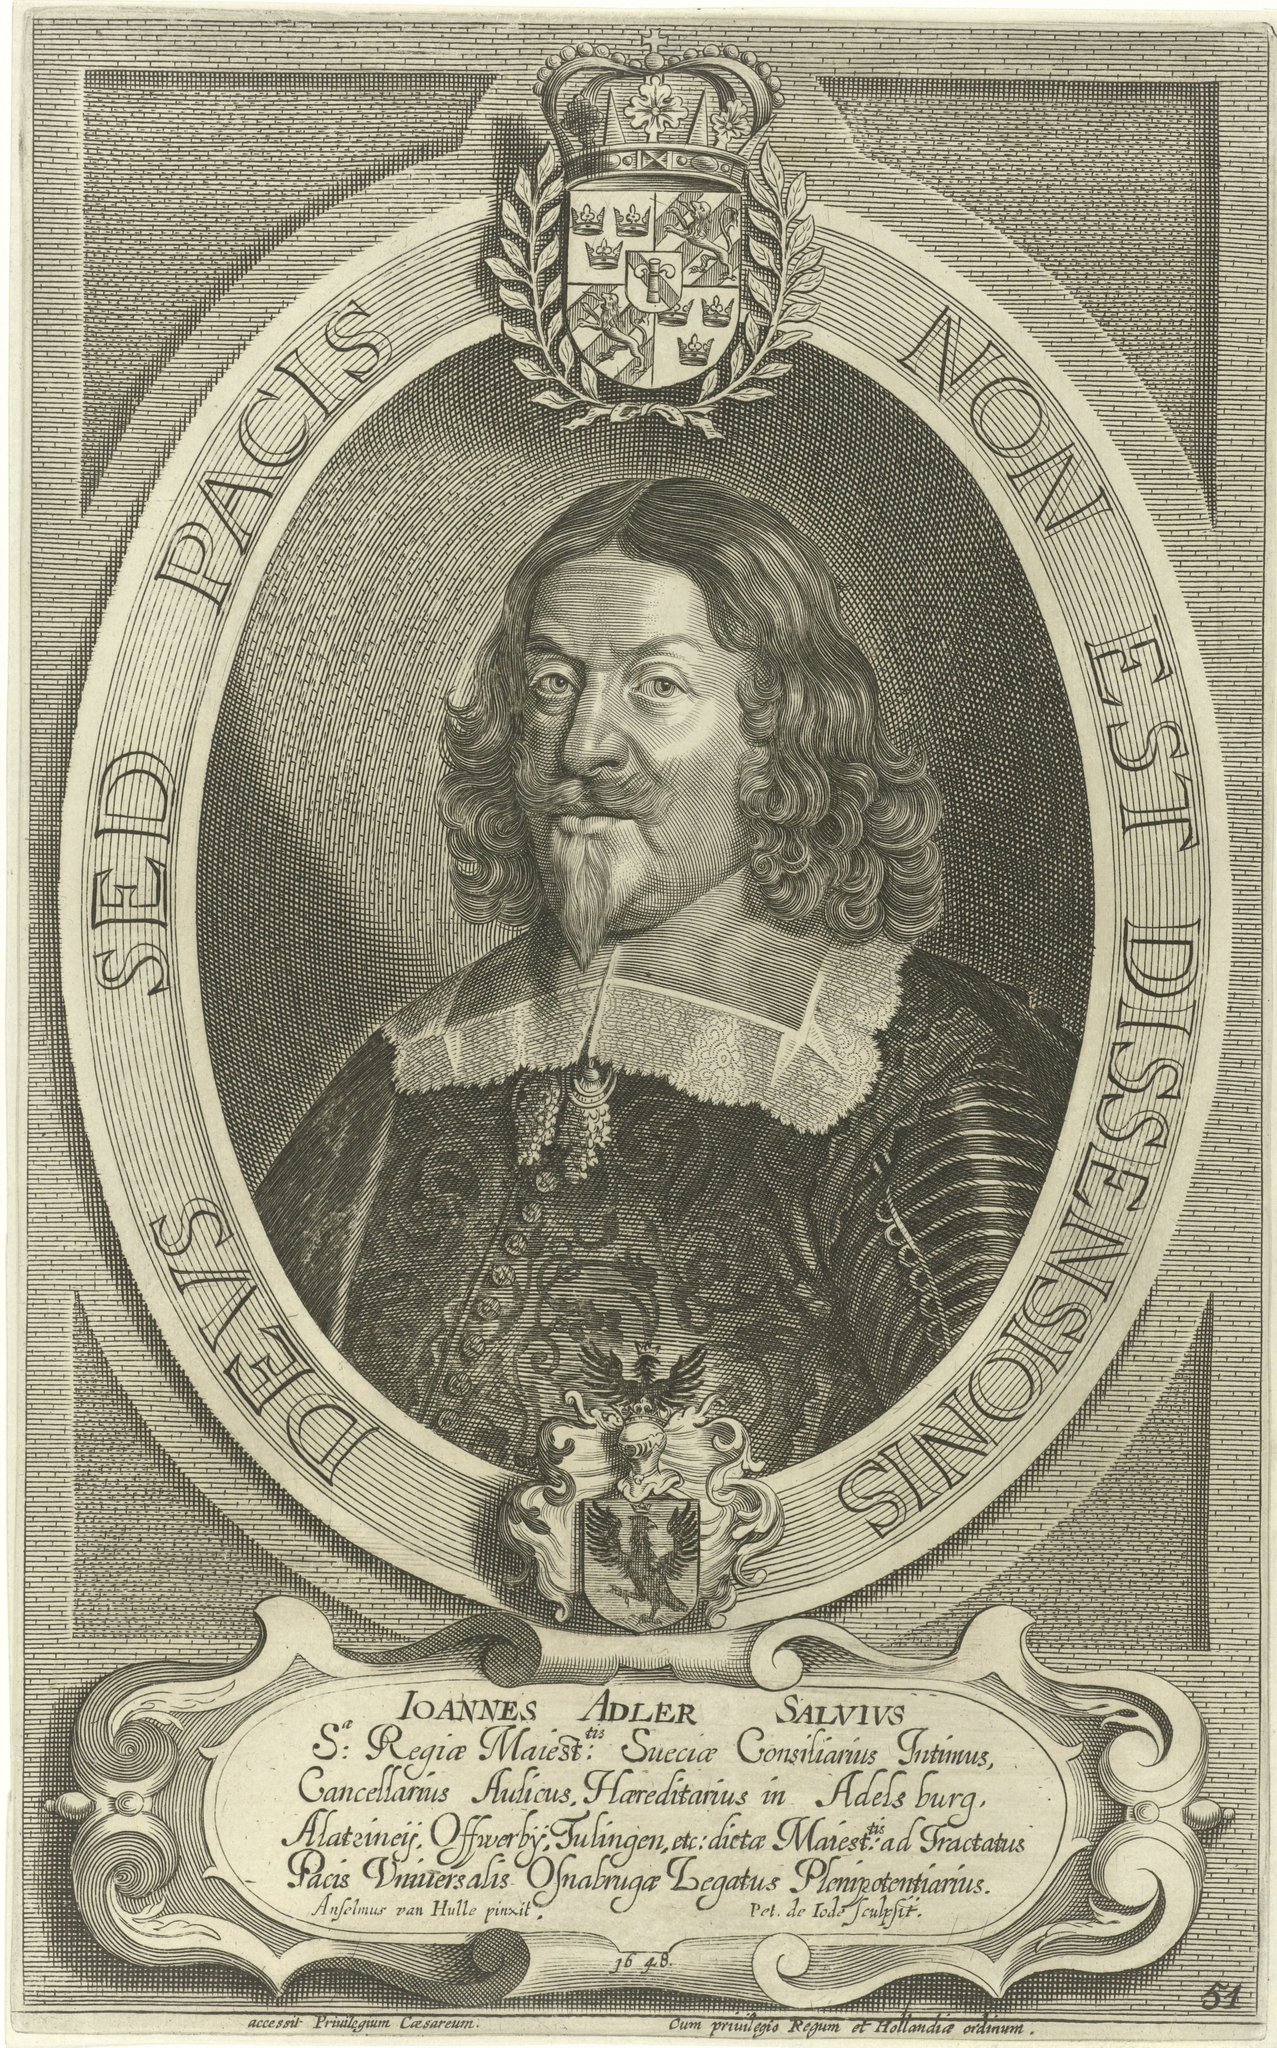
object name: print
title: Hommes illustres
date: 1648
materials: paper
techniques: engraving, etching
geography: antwerp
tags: strängnäs, stockholm, diplomaat, johan adler salvius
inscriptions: collector's mark: Lugt 2228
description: Busteportret van Johan Adler Salvius. Rechtsonder: 51. Het portret is gevat in een ovale omlijsting met vierkant randwerk, het wapenschild van de geportretteerde en een randschrift in het Latijn. In de cartouche een vijfregelig onderschrift in het Latijn. Prent uit een serie portretten naar schilderijen van Anselmus van Hulle van alle gedelegeerden bij de vredesonderhandelingen te Münster en Osnabrück.